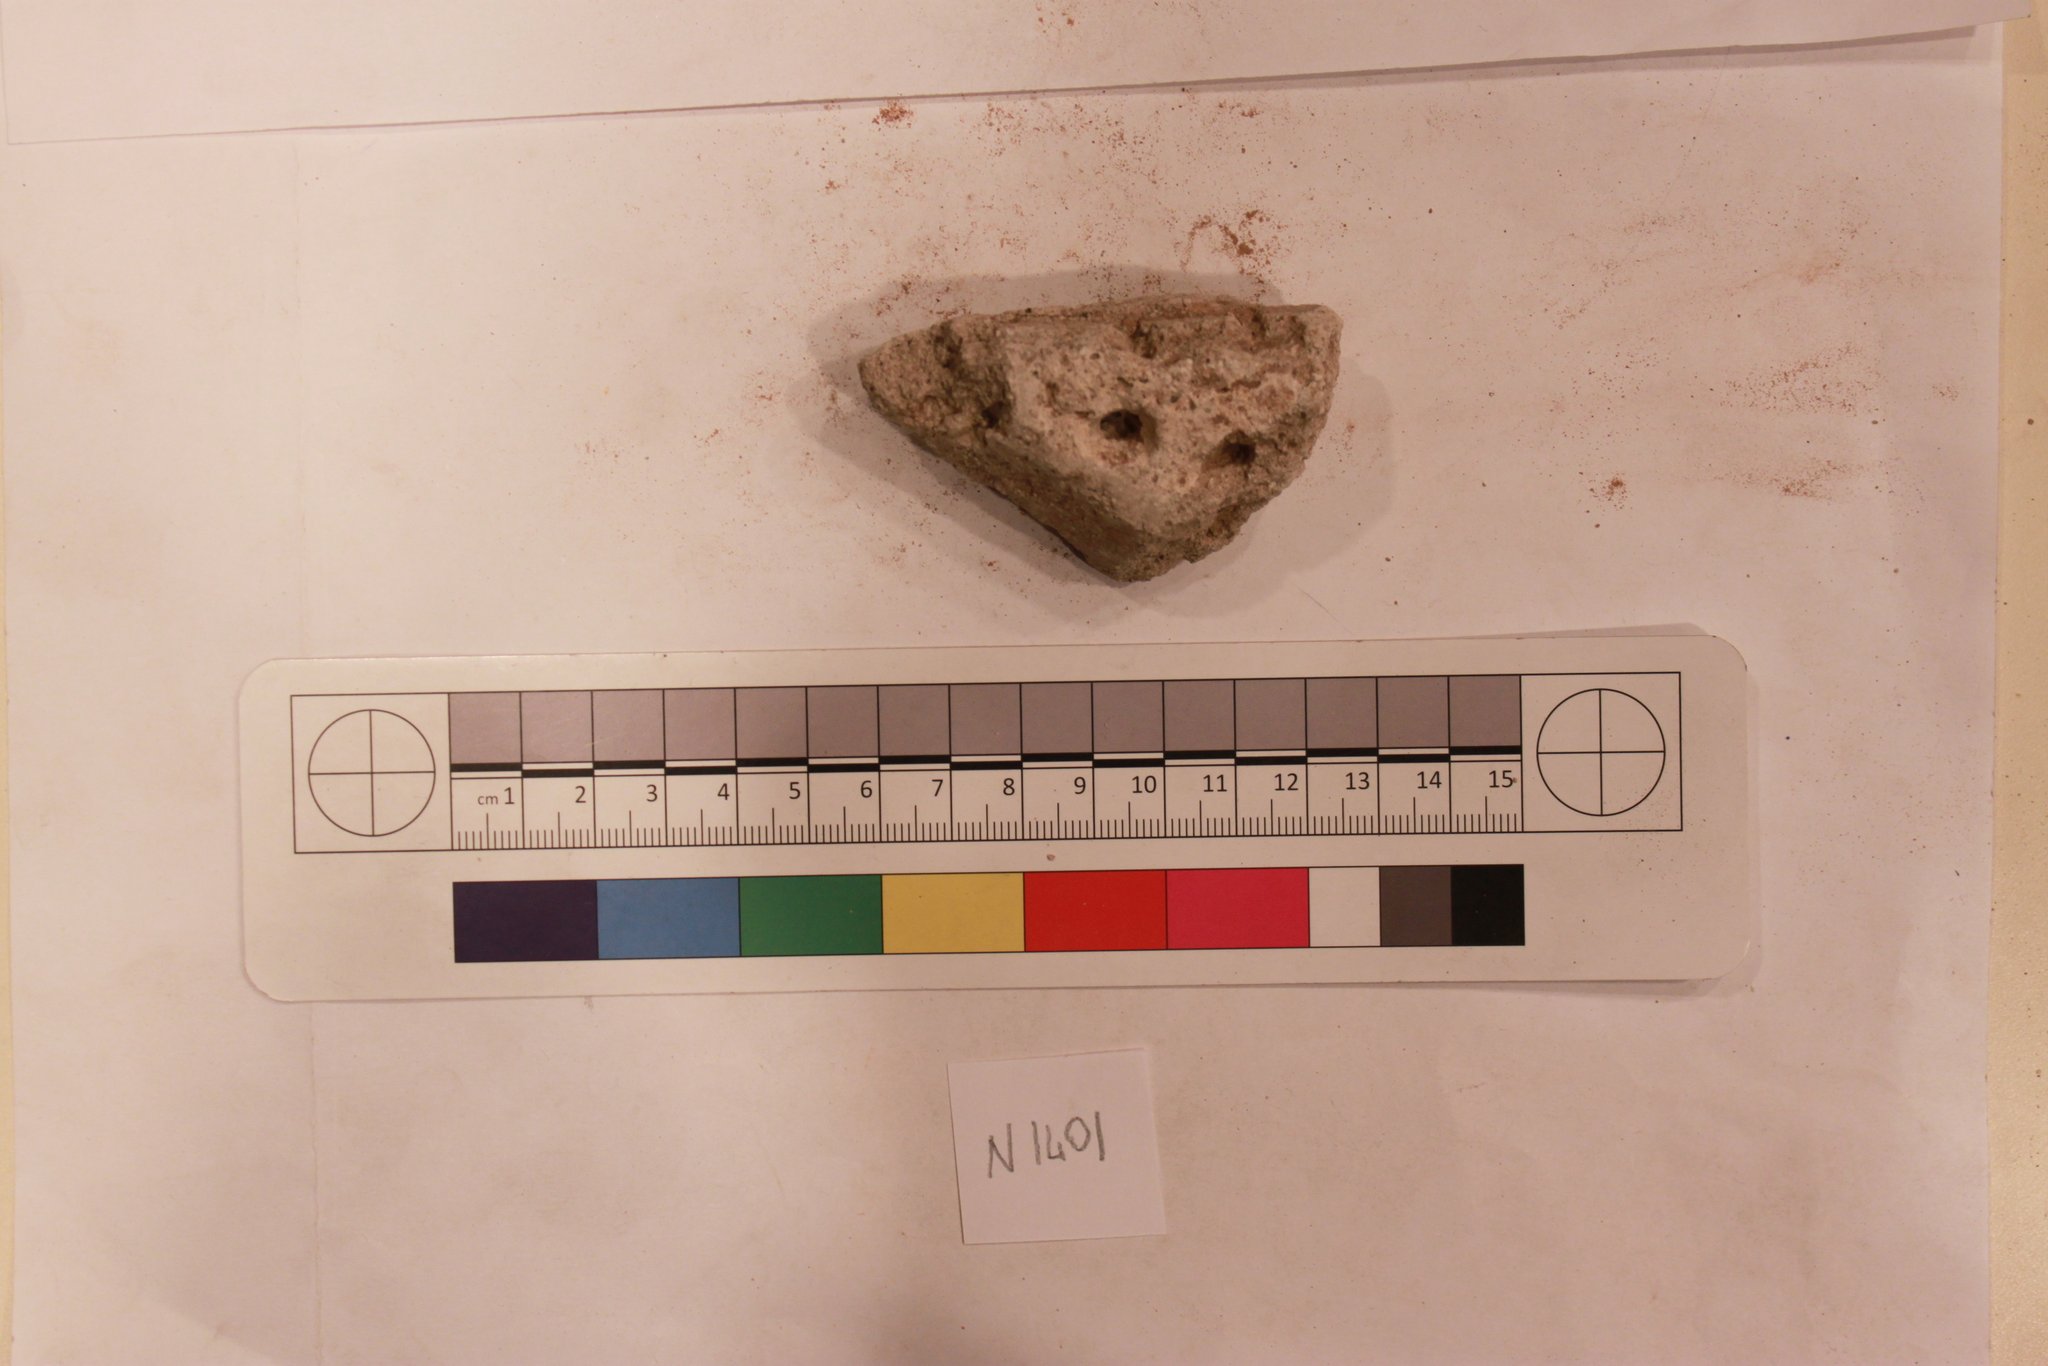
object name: fragment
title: Stucco Fragment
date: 701-1200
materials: plaster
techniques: carving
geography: iran